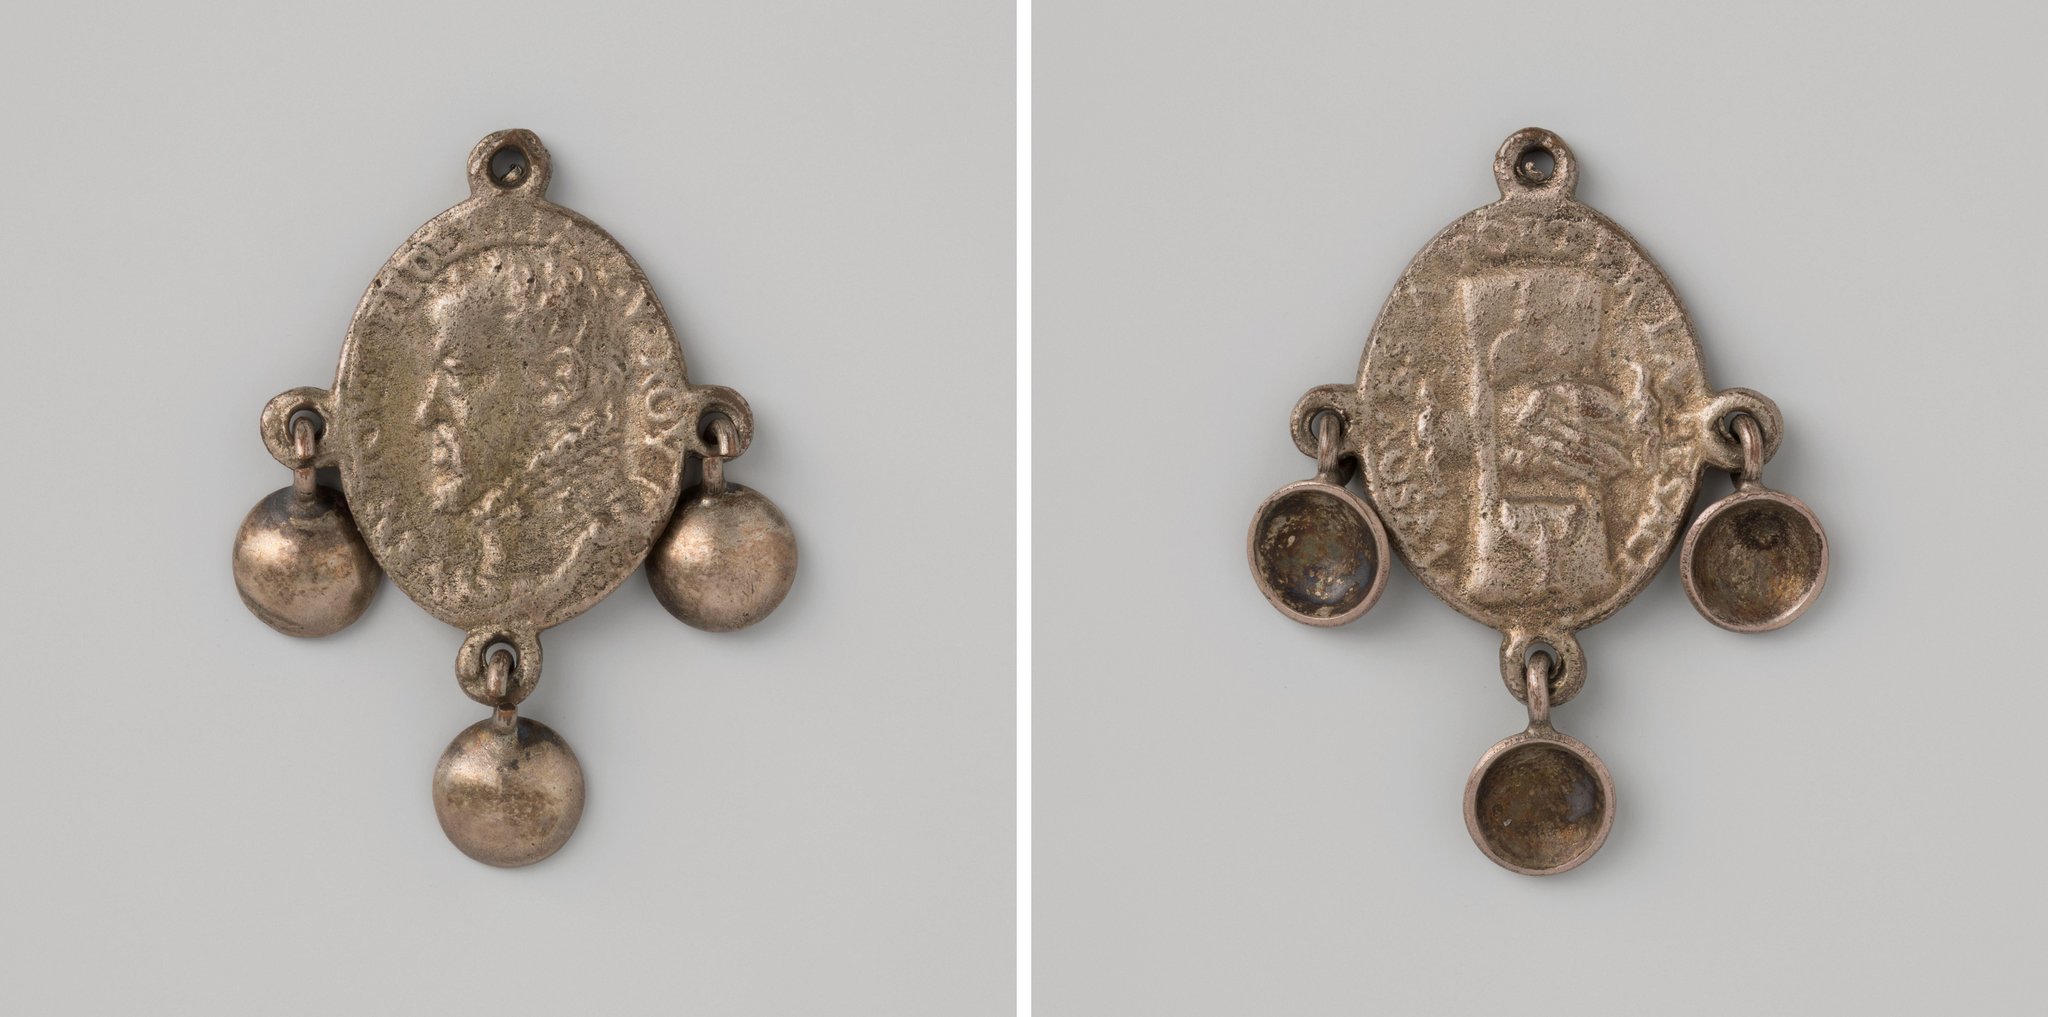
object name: history medal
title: Imitatie geuzenpenning bij driehonderdjarige herdenking van de inname vanDen Briel door de Watergeuzen 1872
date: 1872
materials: brass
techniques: casting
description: Ovalen penning van verzilverd messing met rondom vier draagogen, imitatie van een geuzenpenning: op de voorzijde het portret van Koning Philips II met omschrift, op de keerzijde ineengedrukte handen op een bedeltas, met omschrift, aan de onderste drie draagogen hangen miniatuur bedelnapjes.